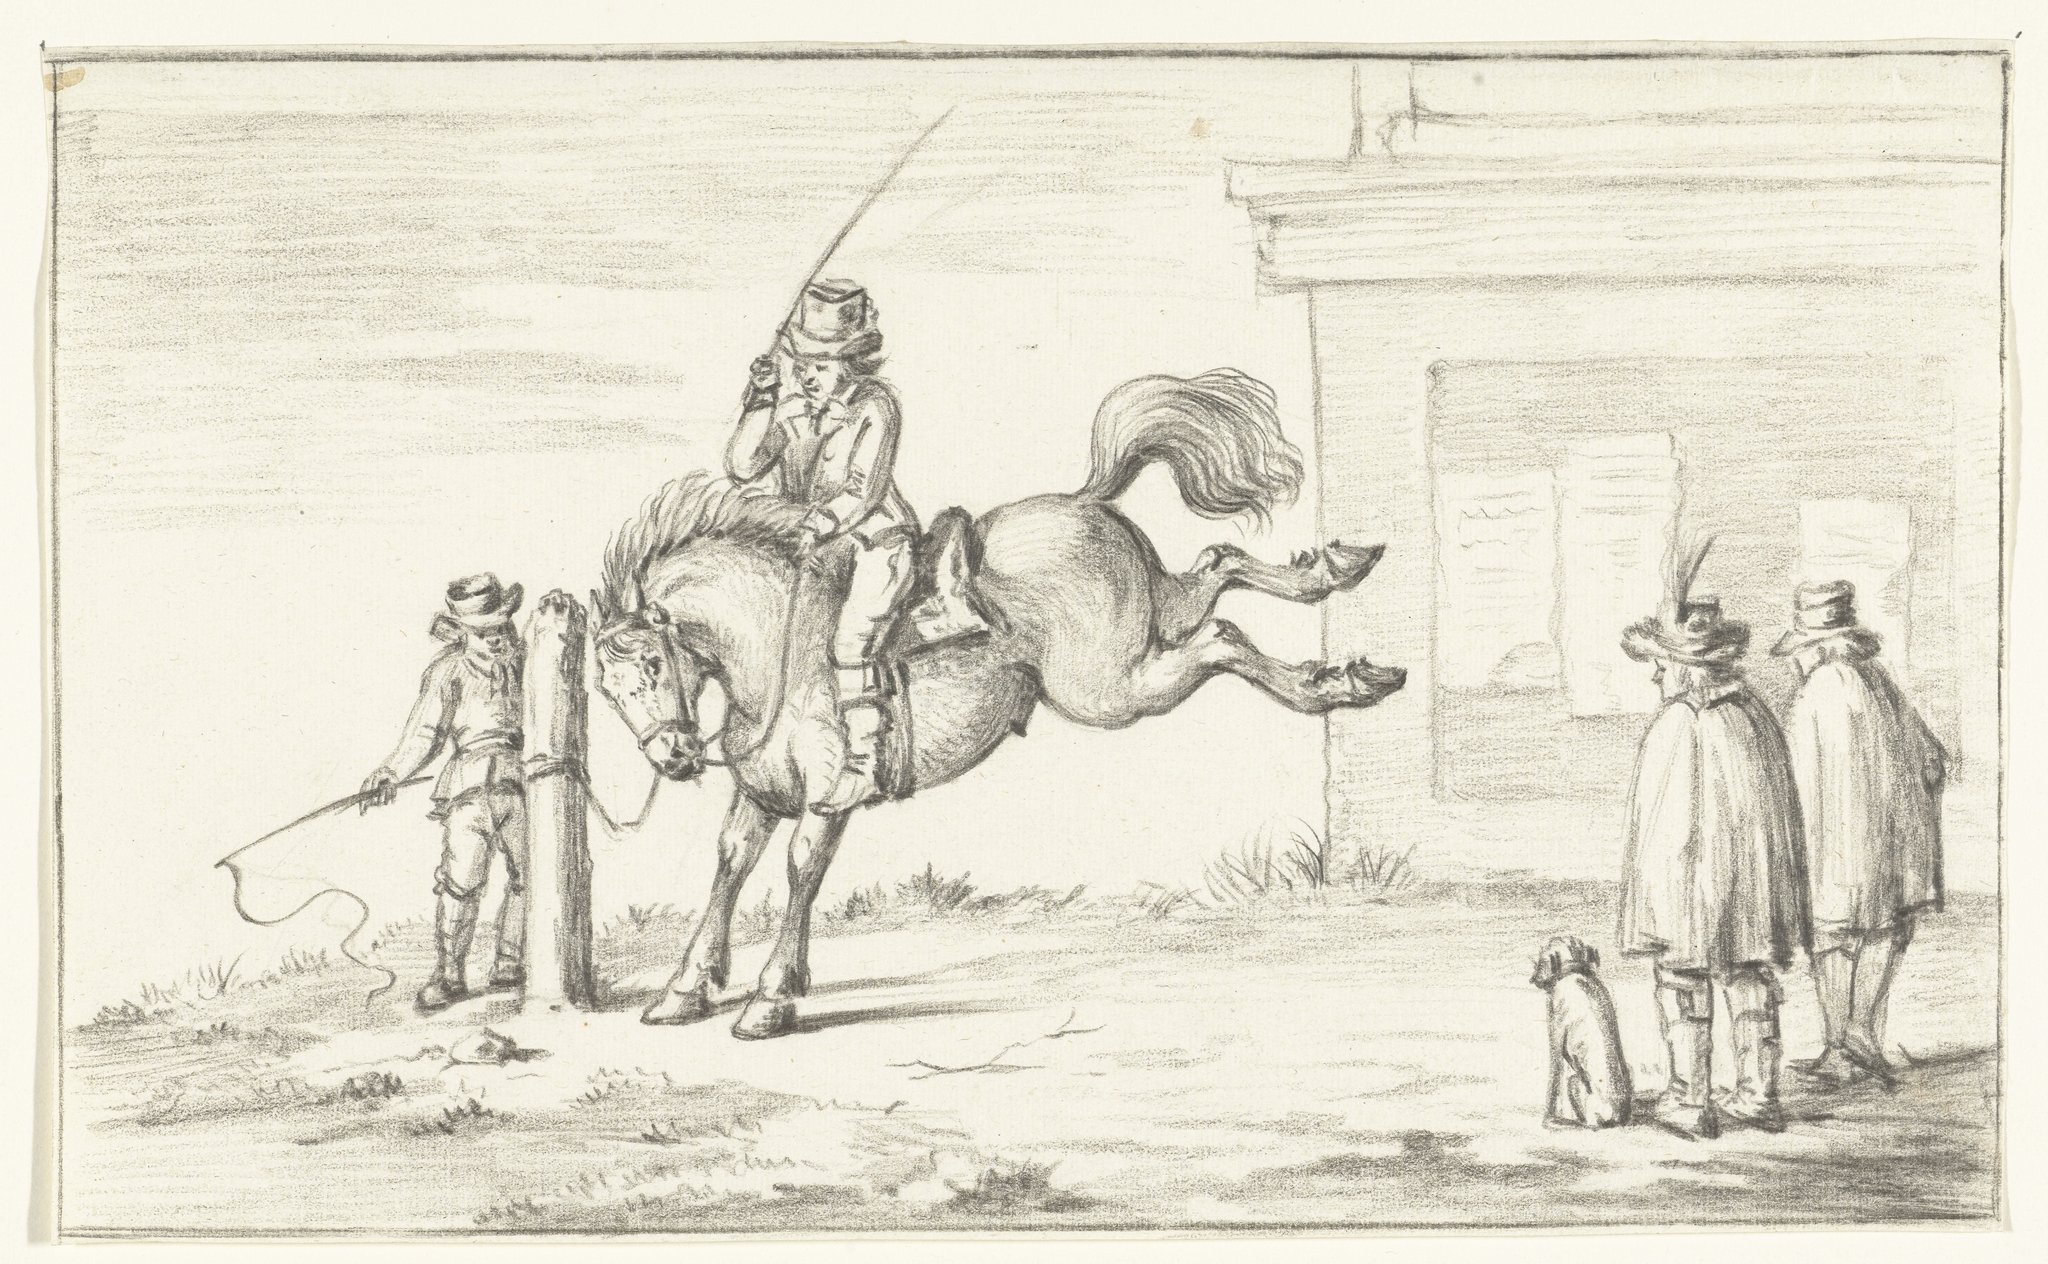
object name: drawing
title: Het temmen van een paard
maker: jean bernard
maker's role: draughtsman, print maker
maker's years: 1765-1833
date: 1775-1833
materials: chalk, paper, pencil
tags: breaking to saddle, bridle, etc. ~ wild horses, horse, kicking (horse in motion)